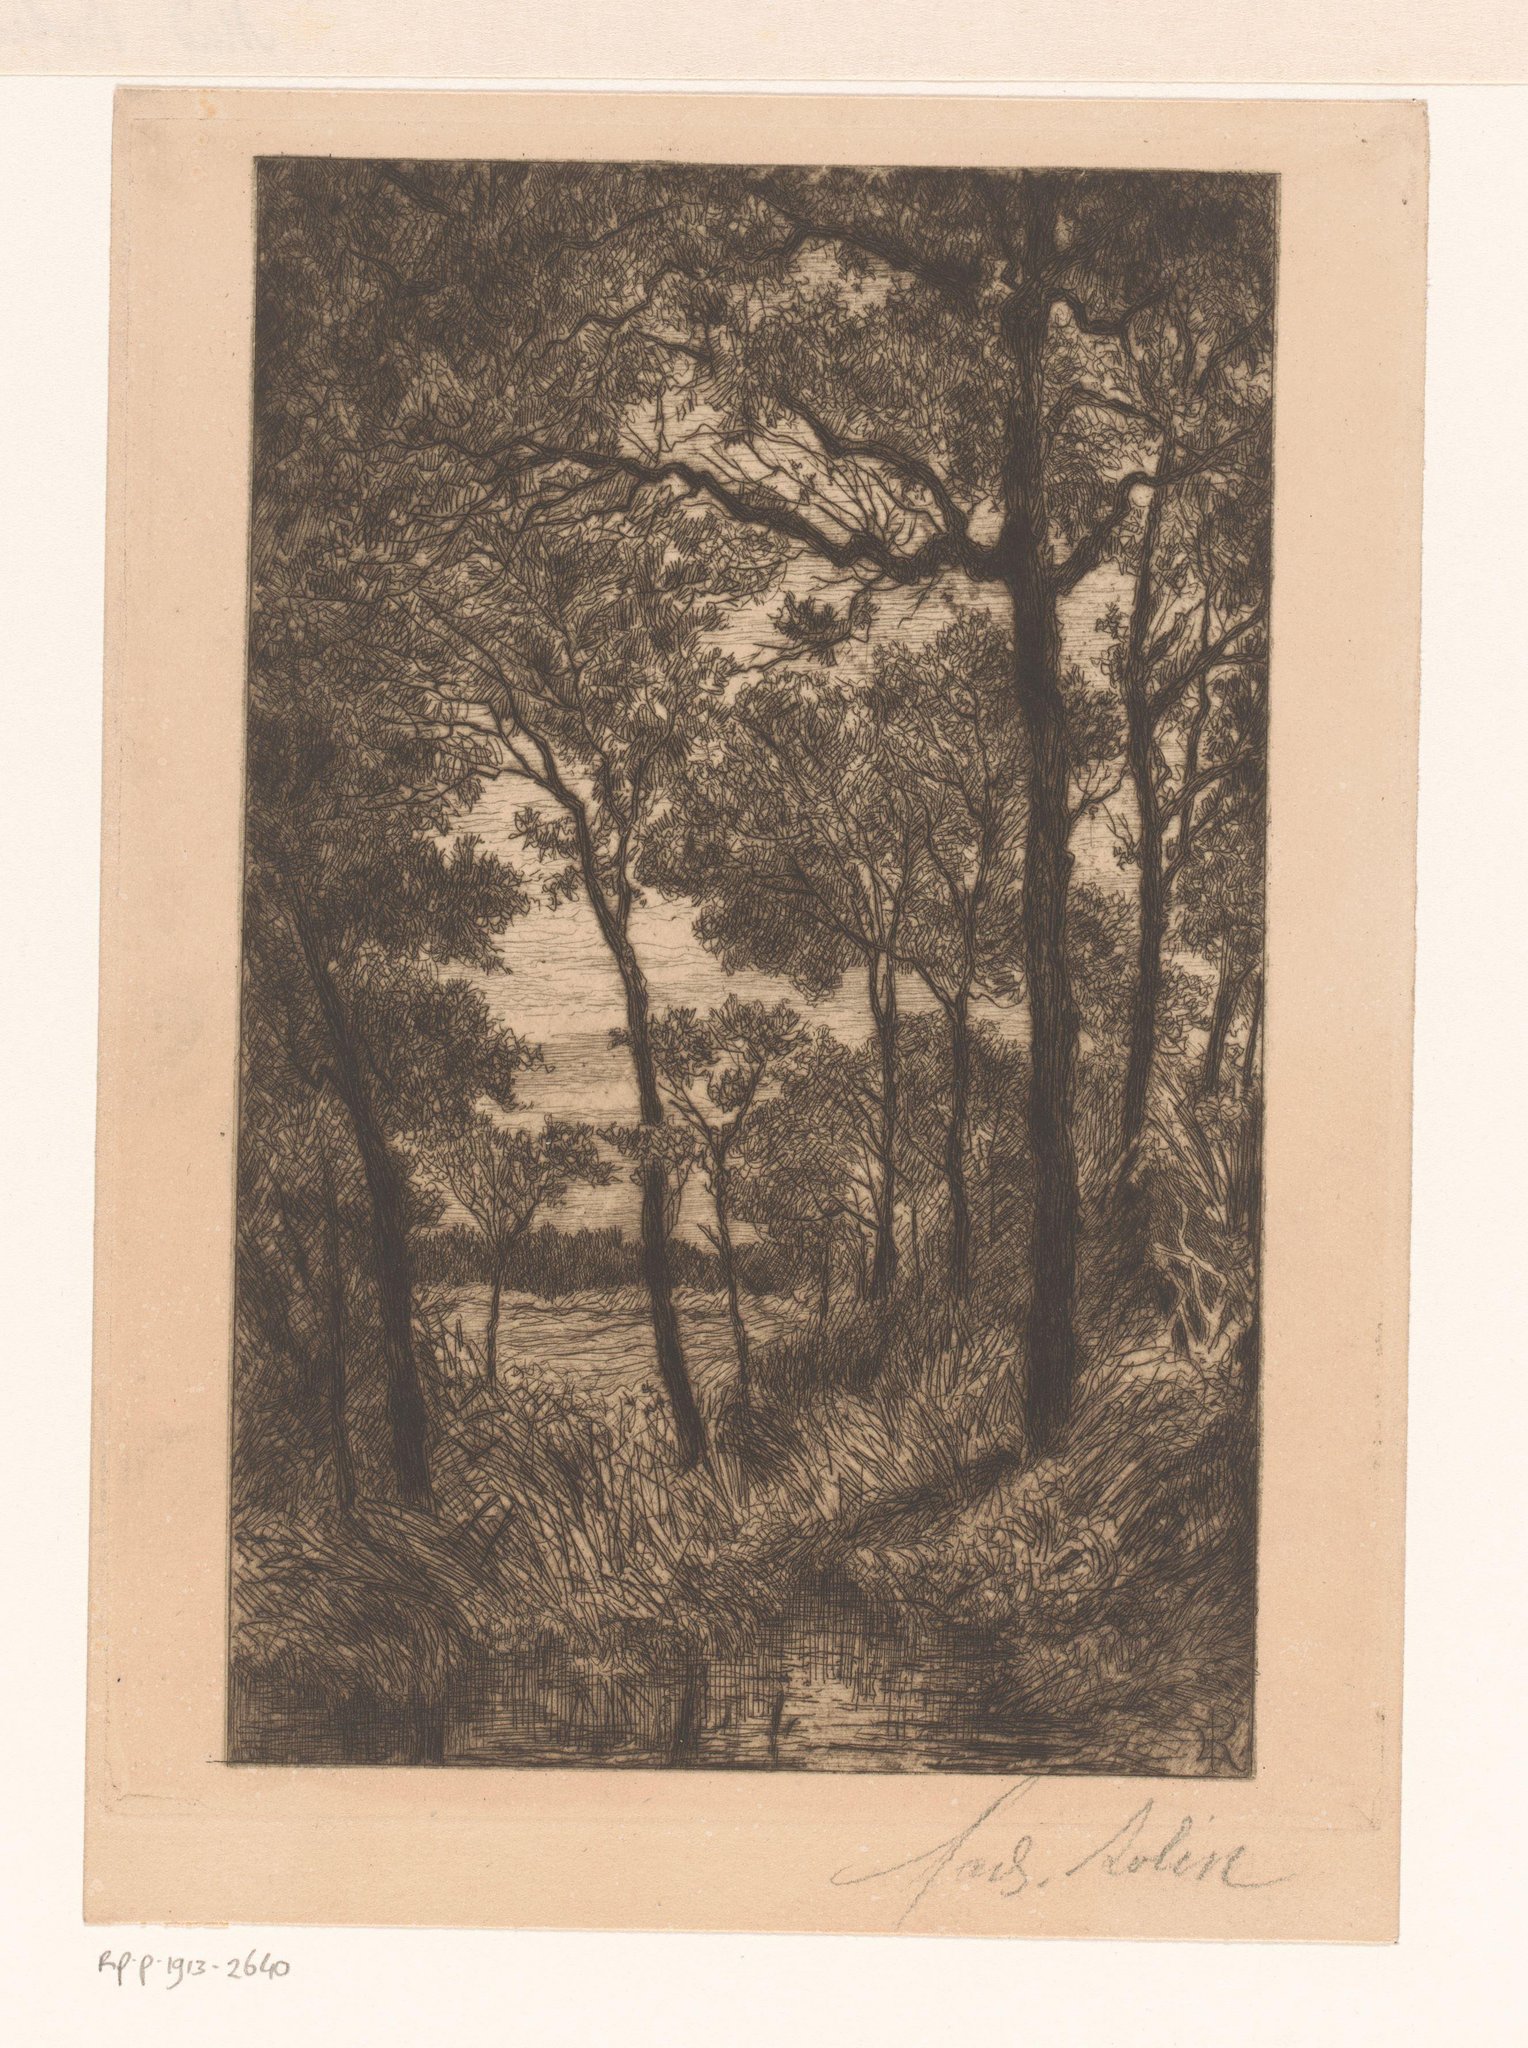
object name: print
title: Waterplas in een bos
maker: emilie rolin-jacquemijns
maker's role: print maker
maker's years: 1842-1906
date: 1852-1906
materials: paper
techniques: etching, intaglio, retroussage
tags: landscapes with waters, waterscapes, seascapes (in the temperate zone), forest, wood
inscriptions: collector's mark: Lugt 2228